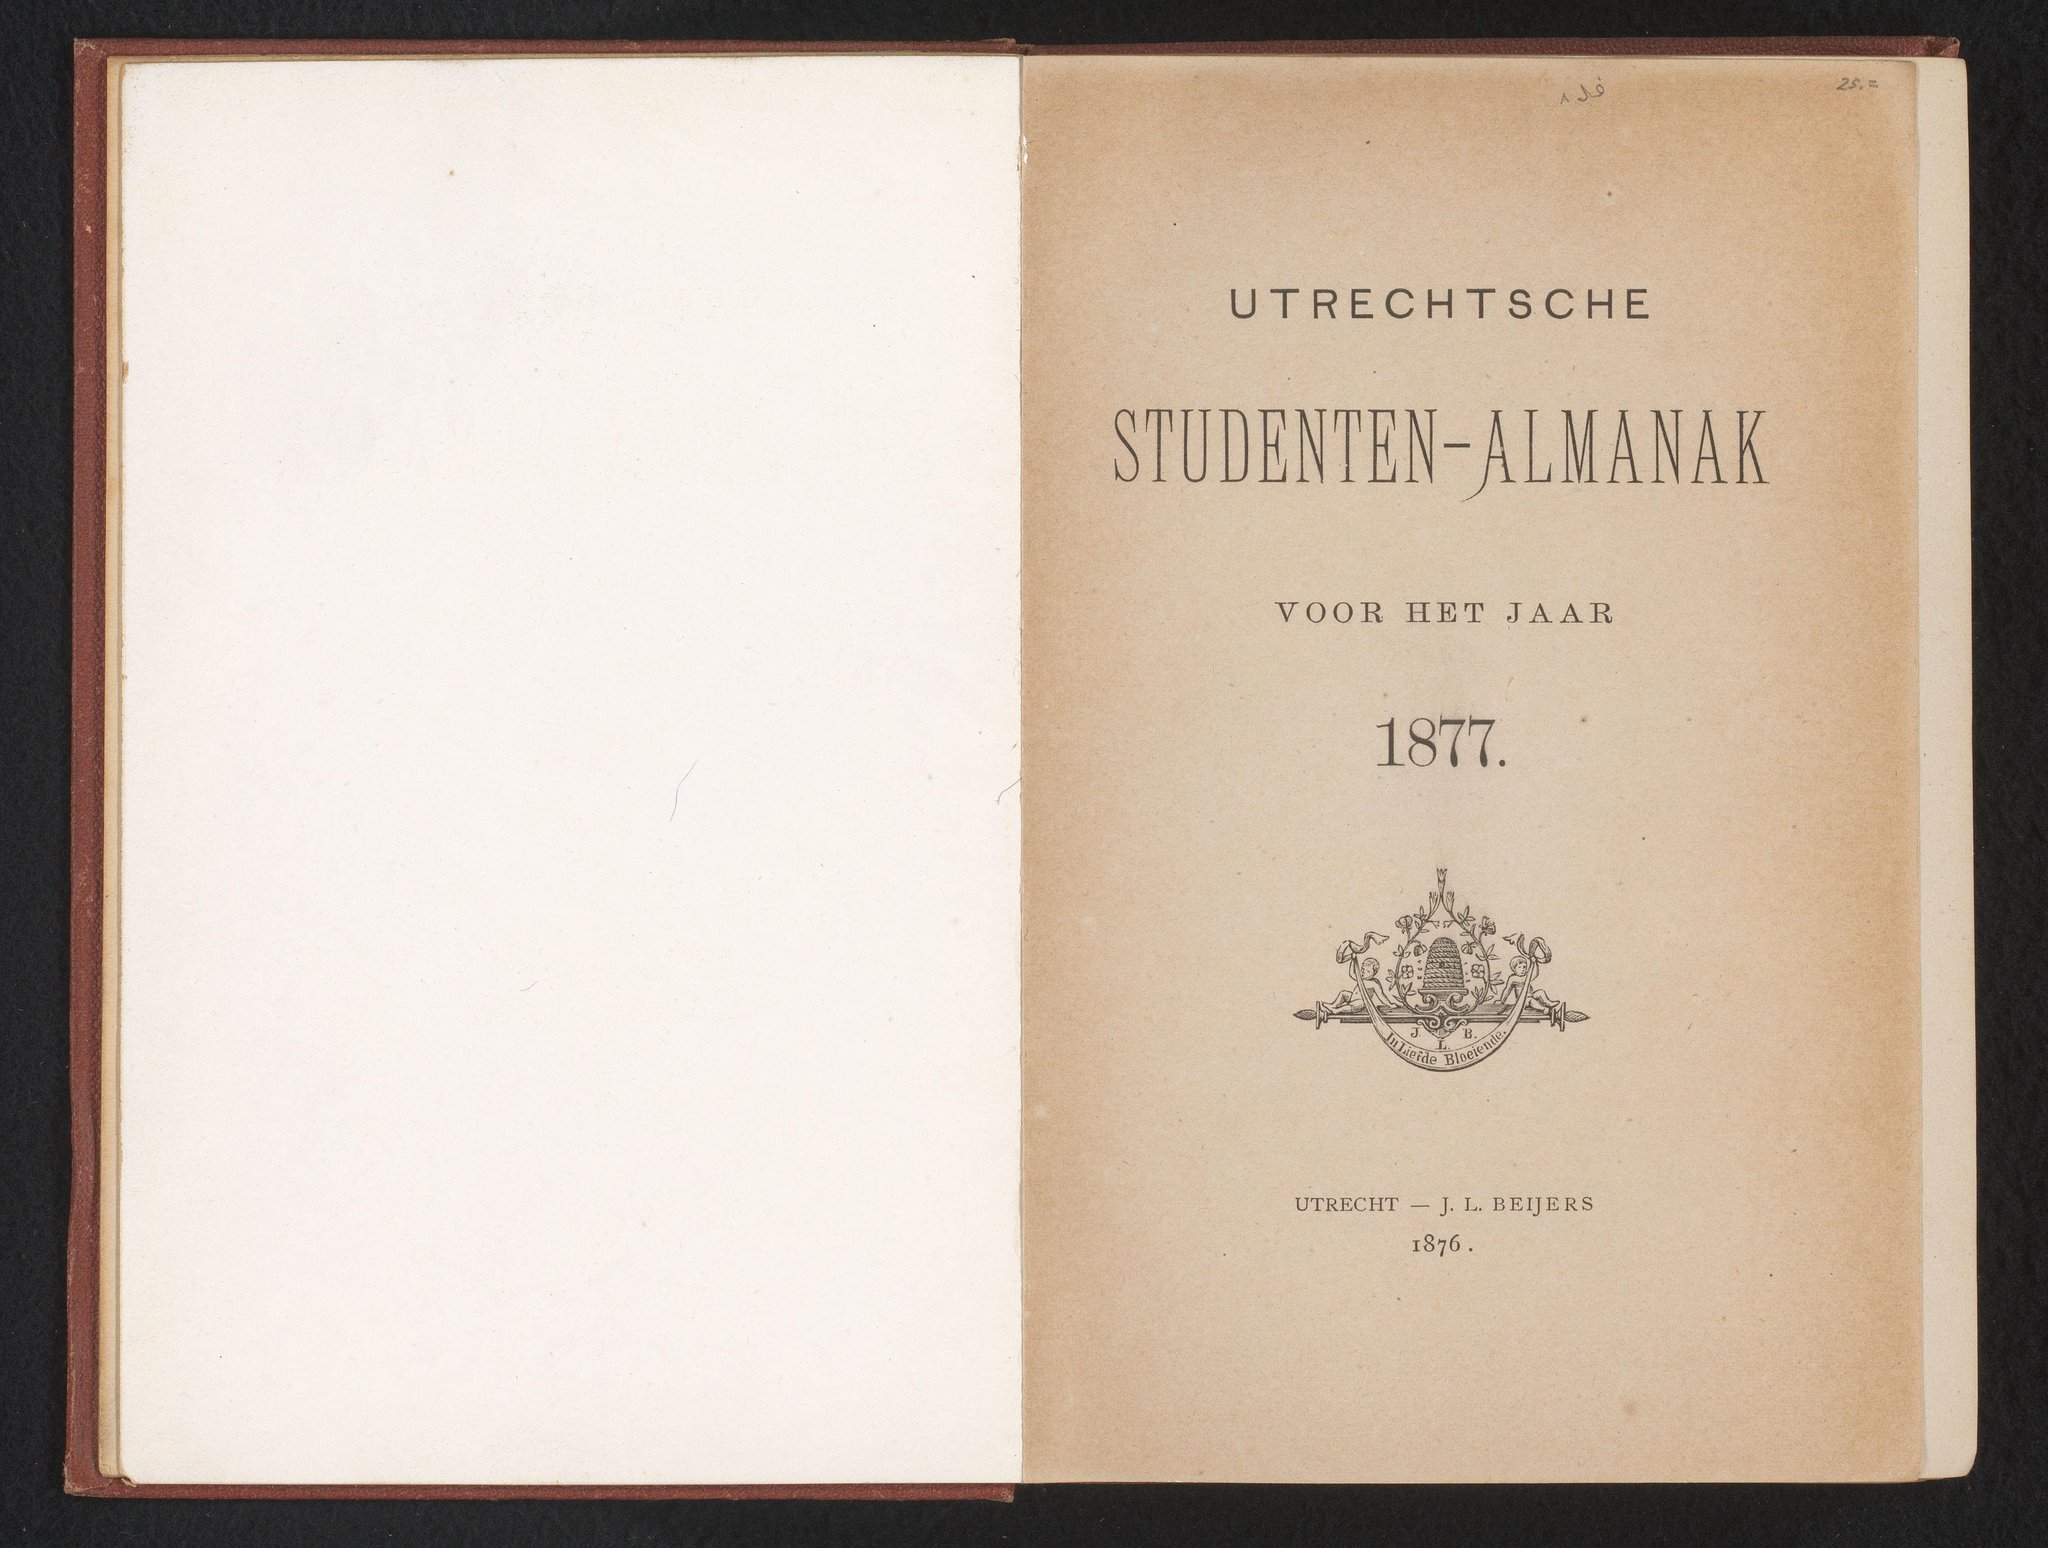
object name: book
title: Utrechtsche studenten-almanak voor het jaar 1877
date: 1876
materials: paper, cardboard, leather, linen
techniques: photograph, letterpress printing, lithograph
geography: rotterdam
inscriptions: number: ‘f2.30’, inscription: ‘J. Monthuan’, company name: ‘Bieshaar & Reckers/ Boekbinderij/ Rotterdam’